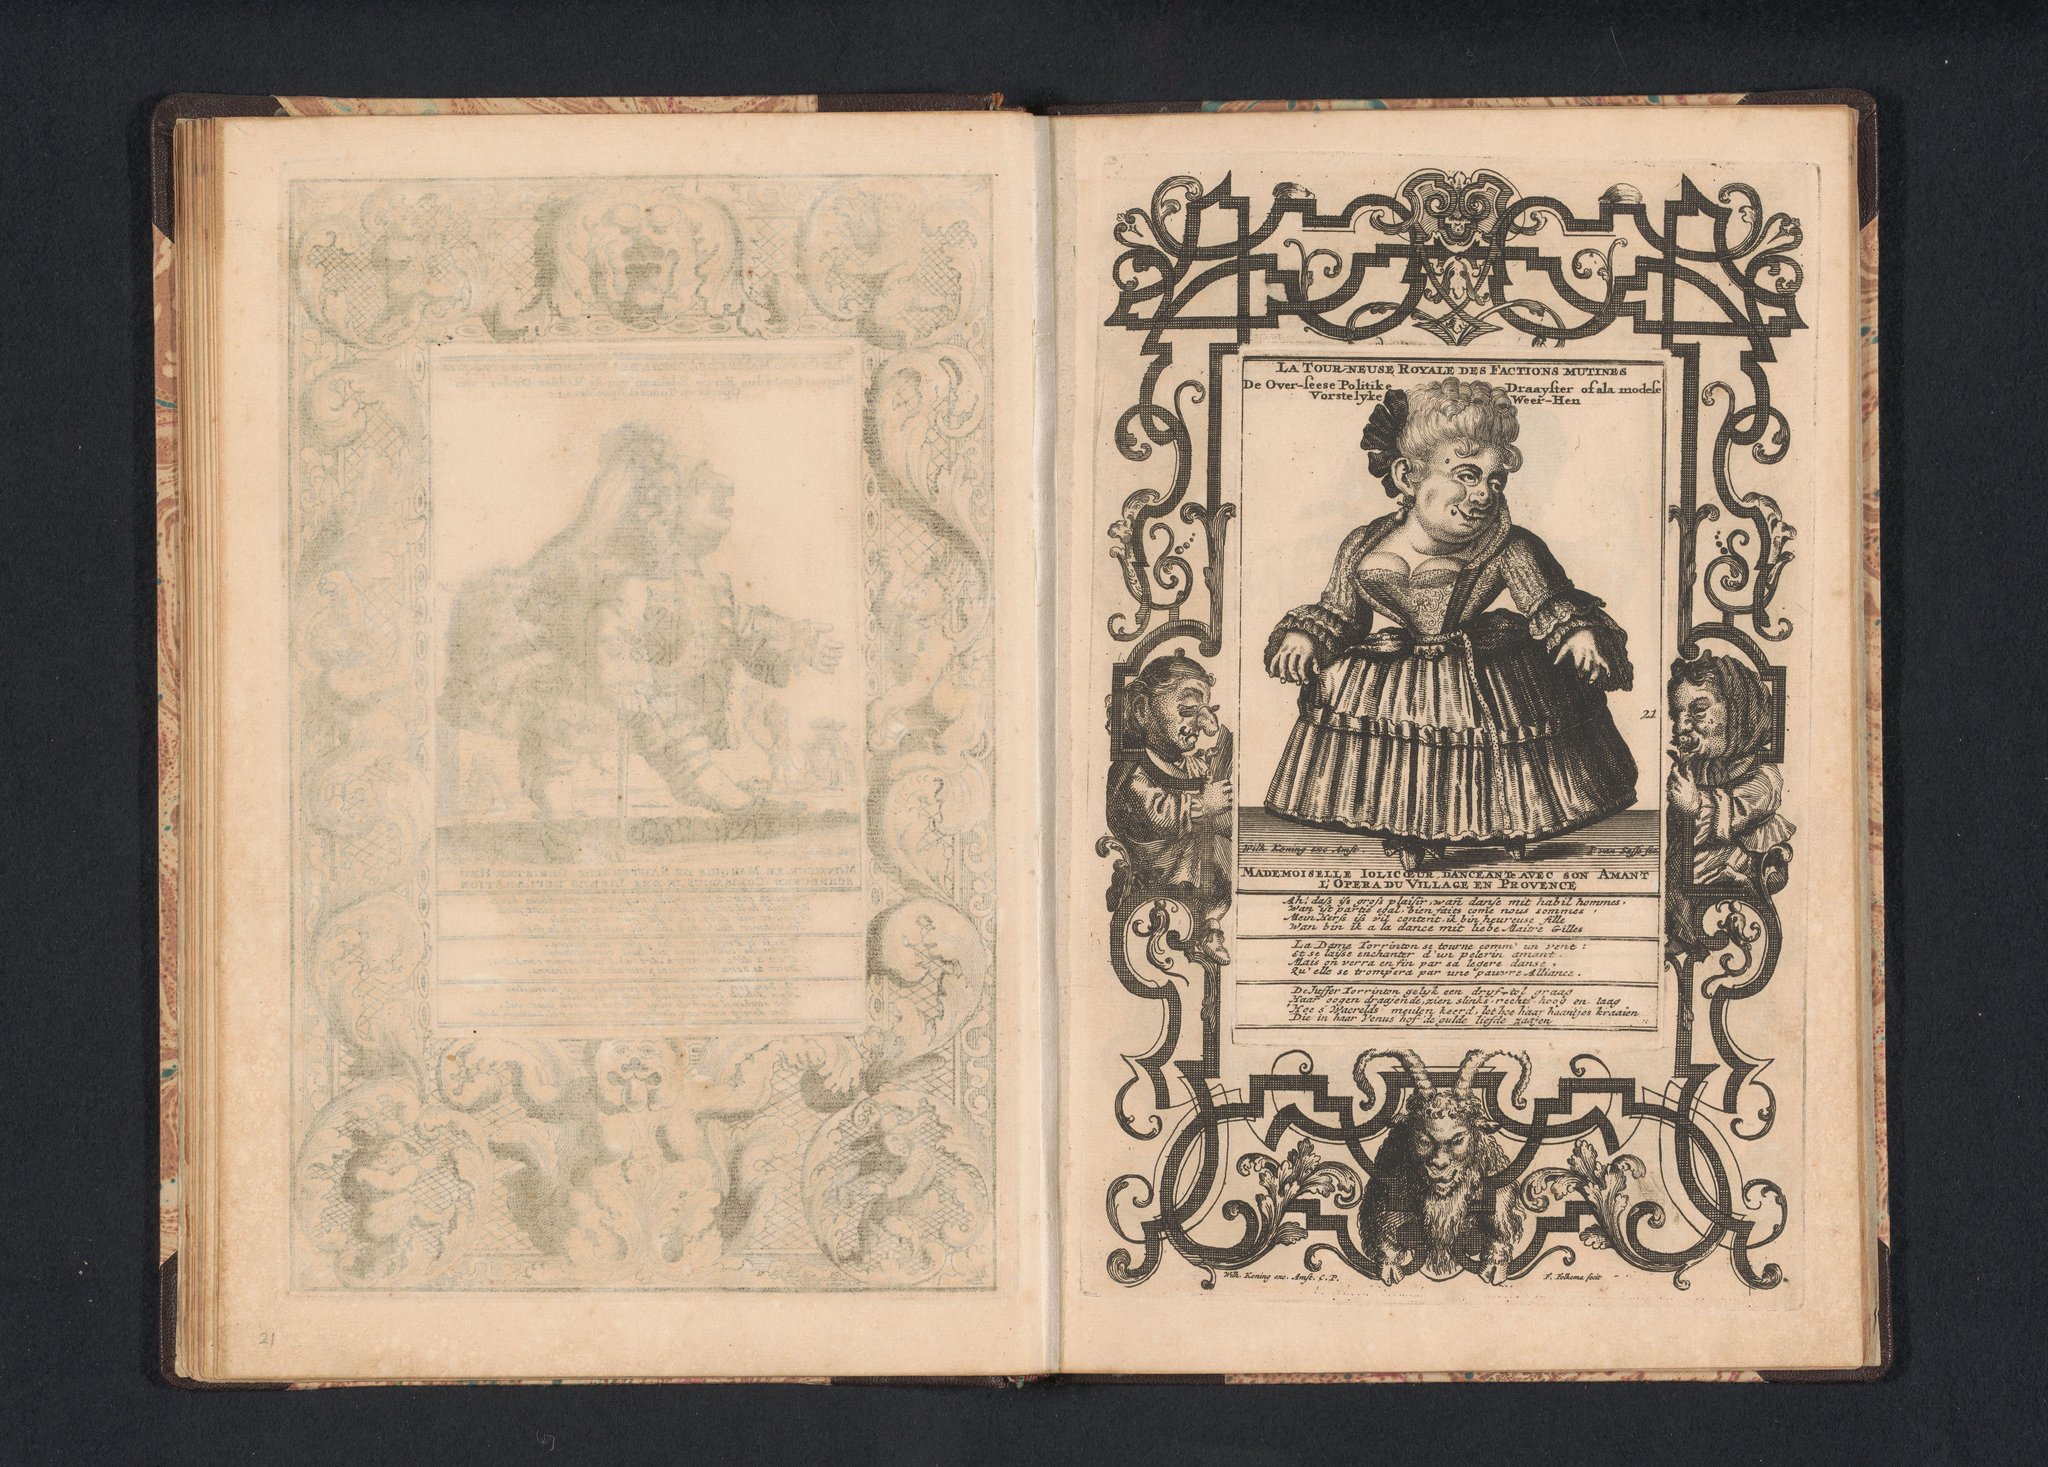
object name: print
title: La Tour-neuse Royale des Factions Mutines / De Over-seese Politike Draayster of ala modese Vorstelyke Weer-Hen / Mademoiselle Iolicoeur, danceante avec son Amant l'Opera du Village en Provence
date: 1716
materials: paper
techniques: etching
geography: amsterdam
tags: caricatures (human types), little people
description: Een kleine mens als de Franse Over-seese Politike Draayster. In het onderschrift verzen in het Duits, Frans en Nederlands. Afdruk binnen een decoratieve omlijsting gedrukt van een aparte plaat met kleine mensen en een bok. Genummerd rechts midden: 21. Onderdeel van de Nederlandse gebonden uitgave uit 1716 van een serie karikaturen van kleine mensen, bekend als Het Dwergentooneel, gekopieerd naar een ouder Duits voorbeeld.